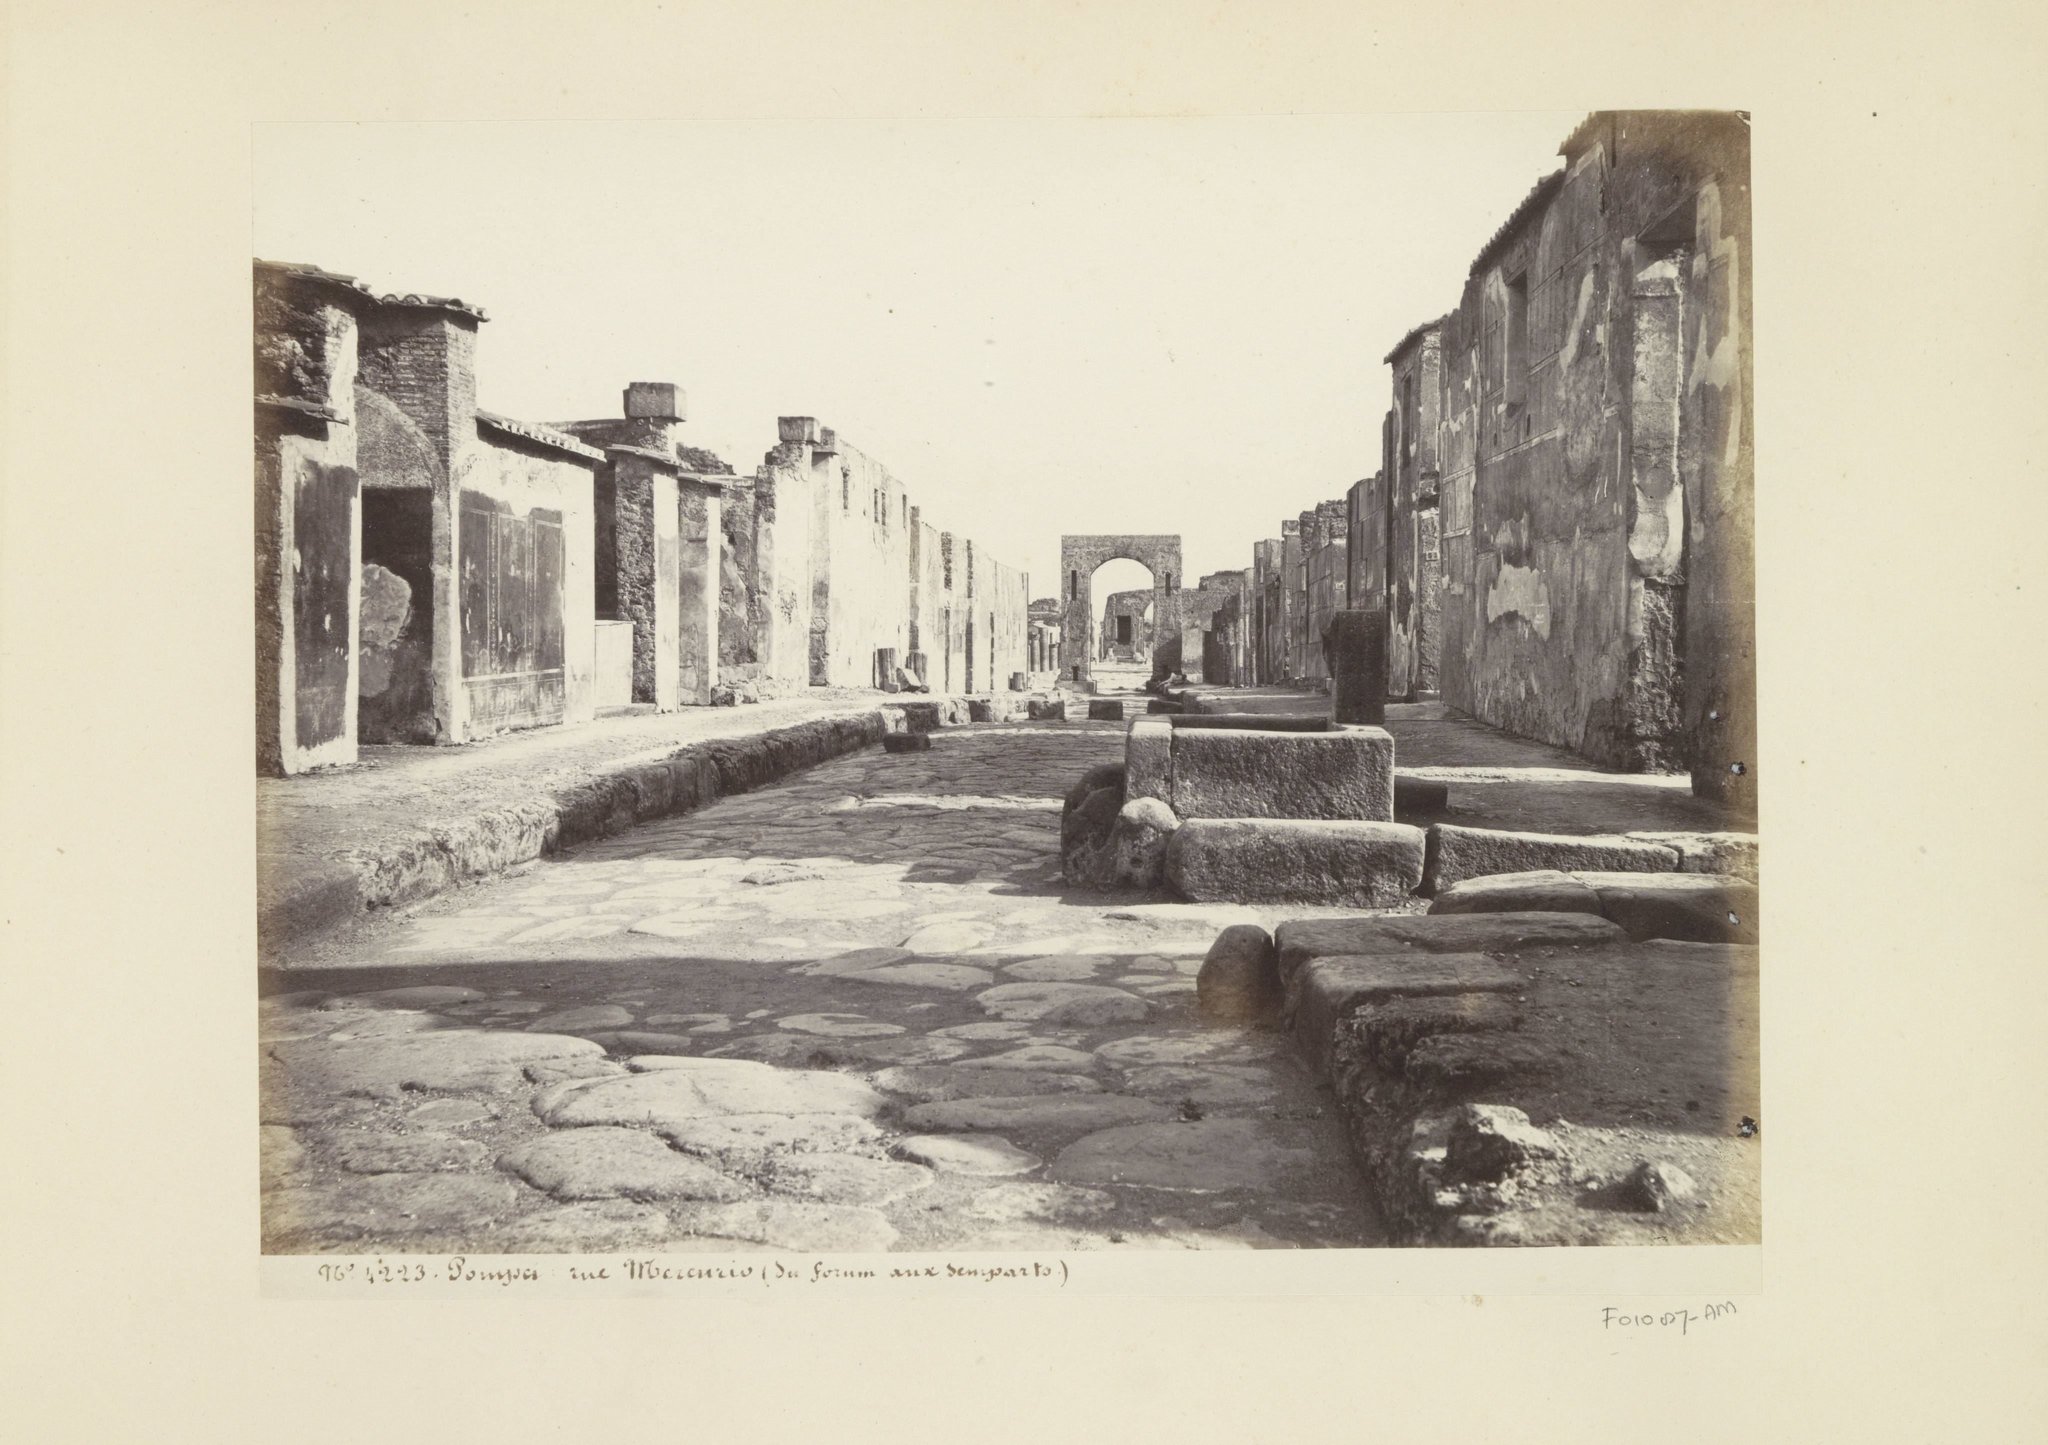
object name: photograph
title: Pompei: rue Mercurio (du forum aux remparts.)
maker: Anonymous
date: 1865-1875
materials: paper, photographic support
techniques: albumen print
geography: pompeii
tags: excavation ~ archaeology, pompeii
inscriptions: negative number: ‘4223’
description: Onderdeel van Reisalbum met foto's van bezienswaardigheden in Napels en omgeving.